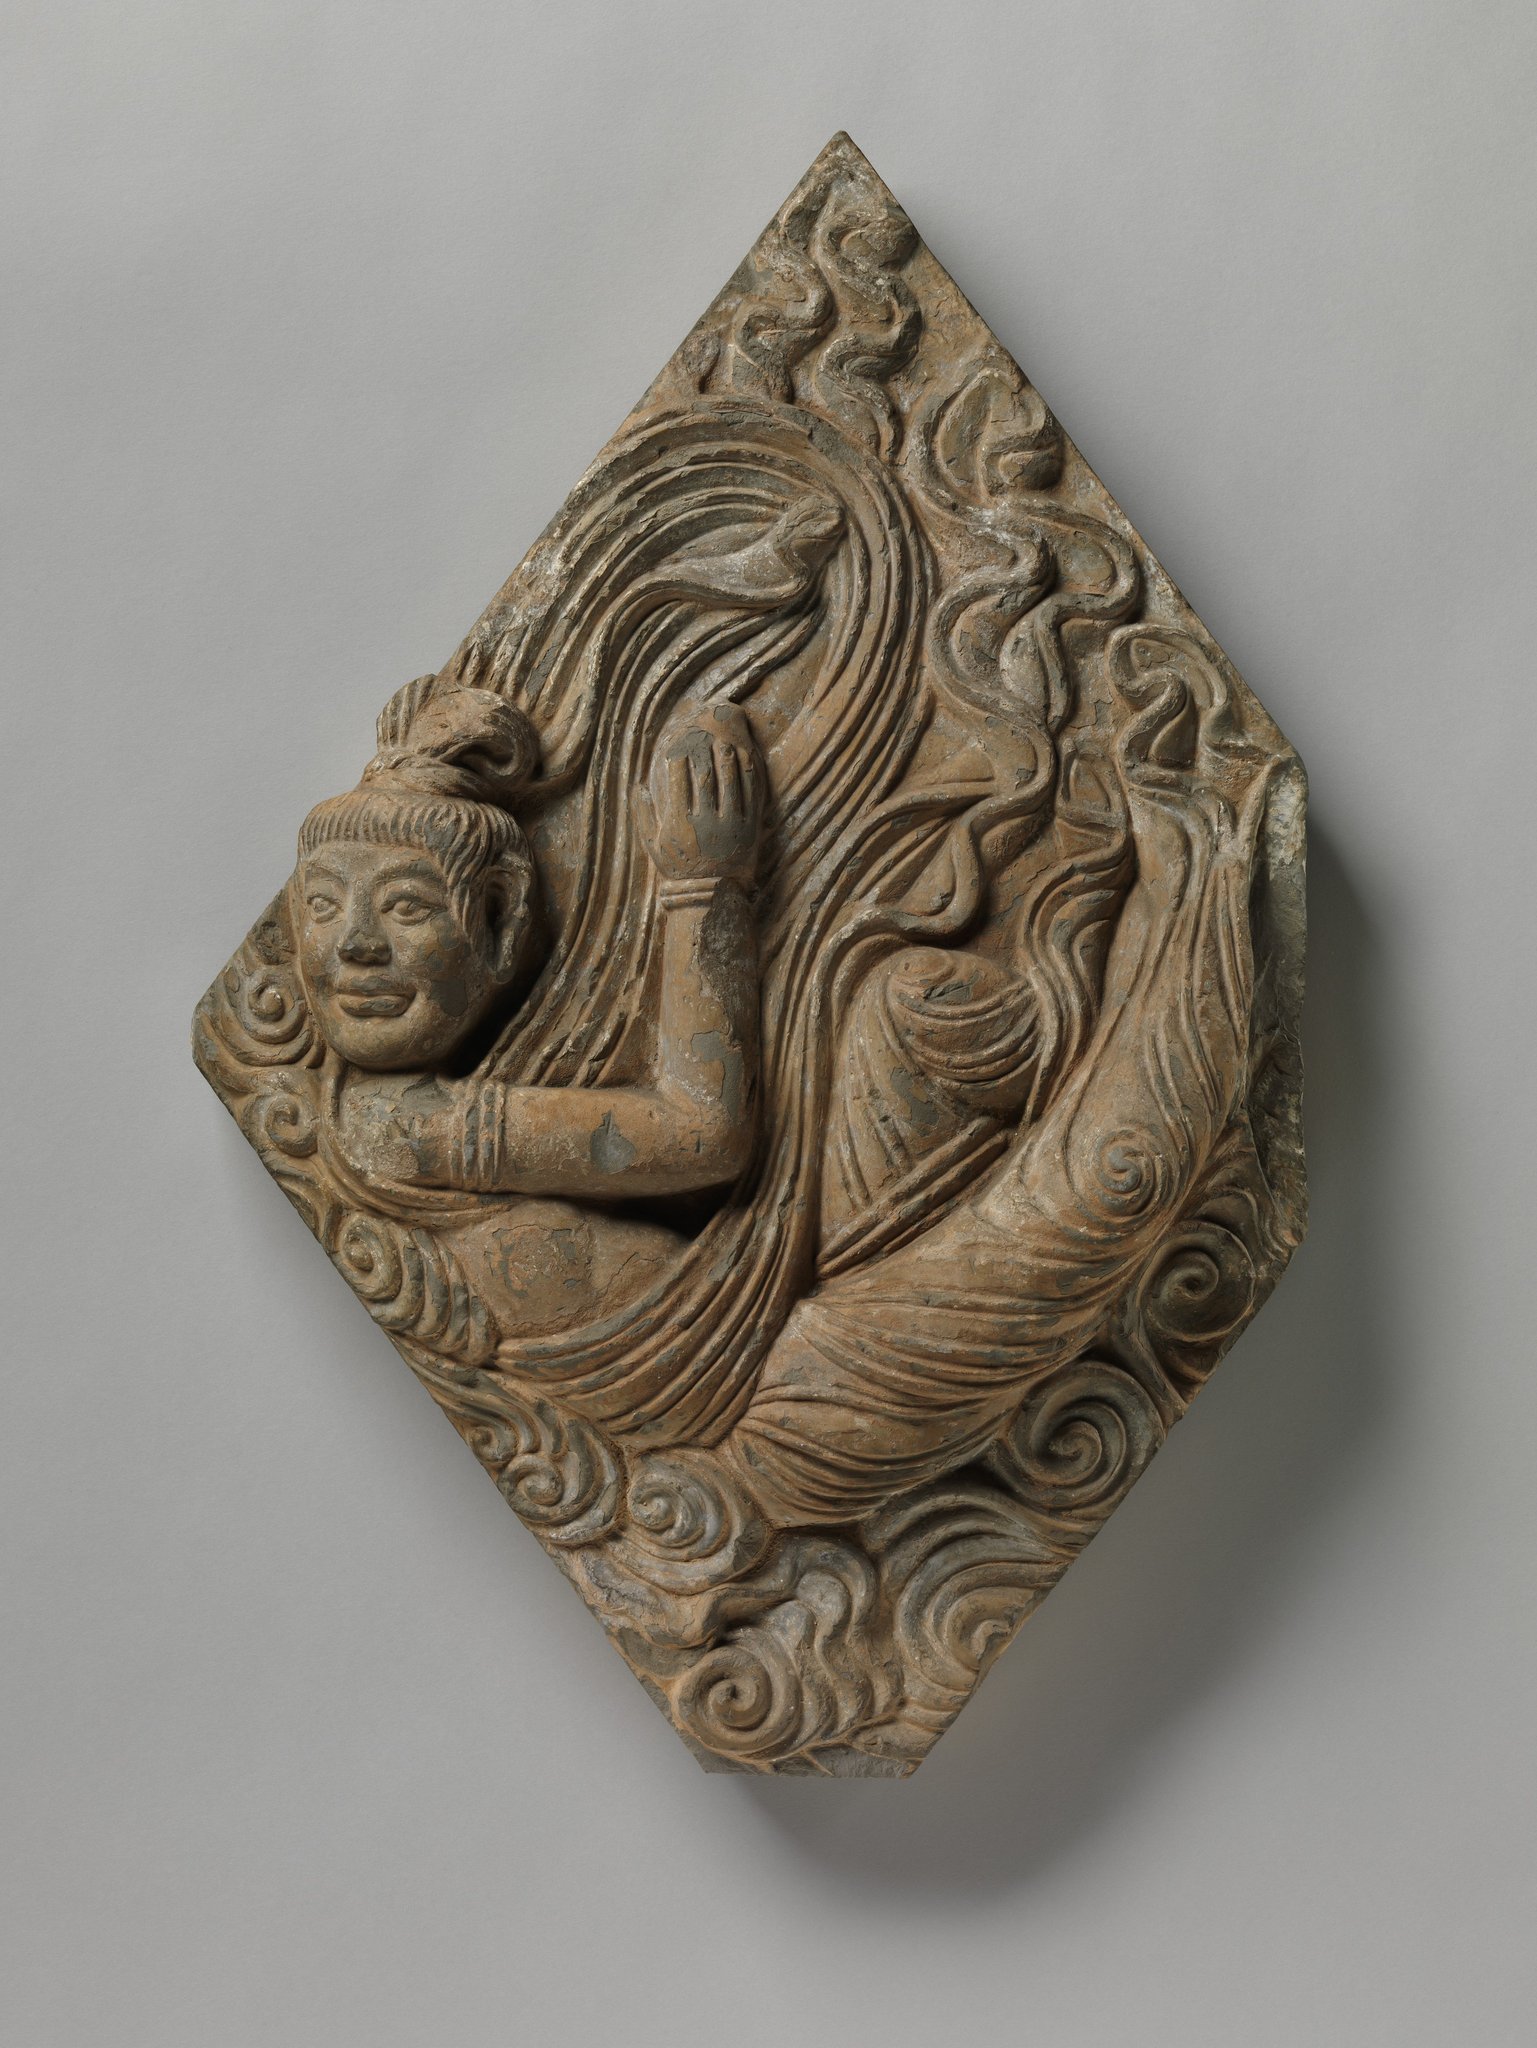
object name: relief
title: Flying Celestial Apsara (Feitian 飛天)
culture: chinese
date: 601-700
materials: earthenware, pigment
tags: women